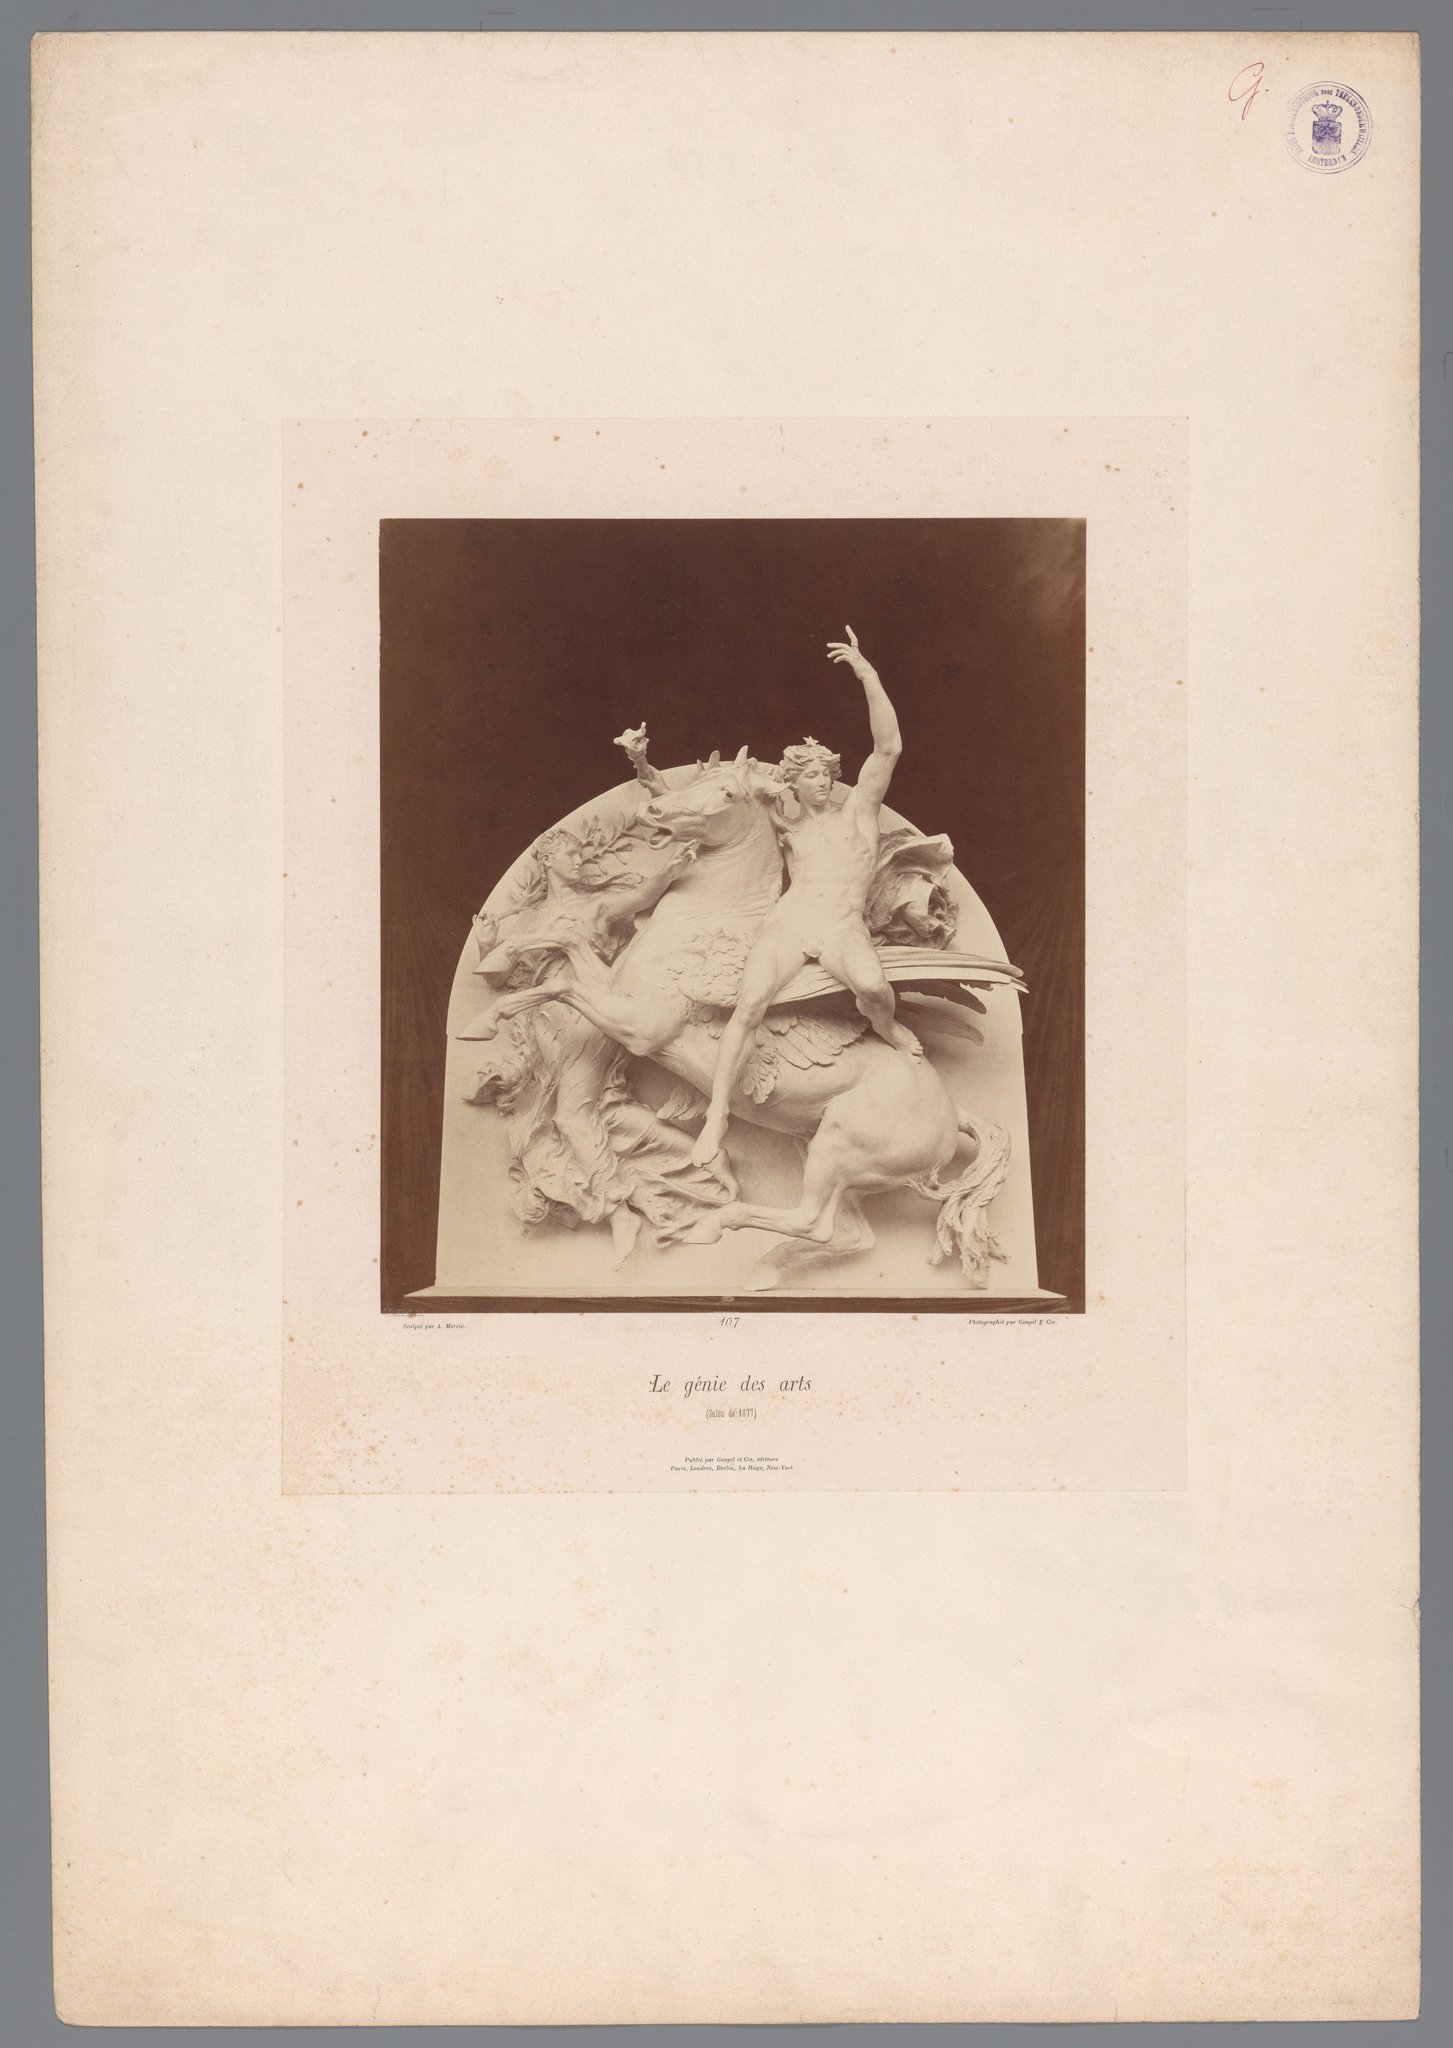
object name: photograph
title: Le génie des arts (Salon de 1877)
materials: cardboard, paper, photographic support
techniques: albumen print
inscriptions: stamp, : ‘G’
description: Sculptuur door A. Mercié van een gevleugeld paard met een man als berijder en een vrouw daarnaast.